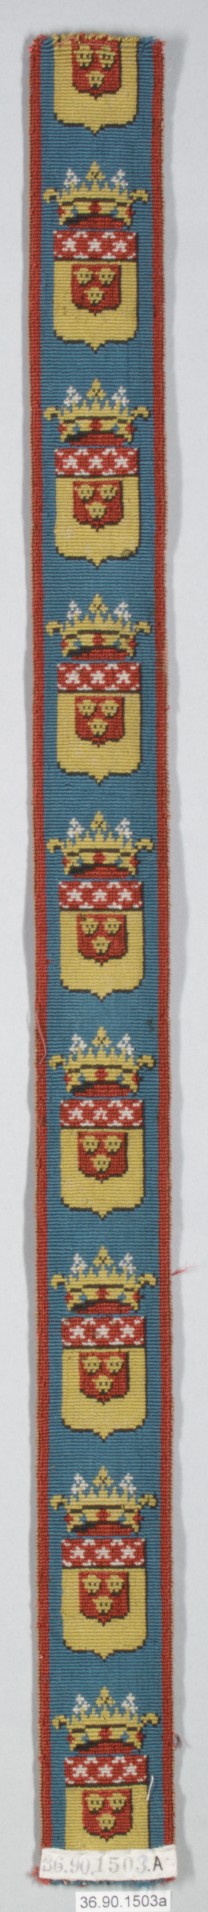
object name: galloon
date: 1701-1900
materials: silk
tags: coat of arms